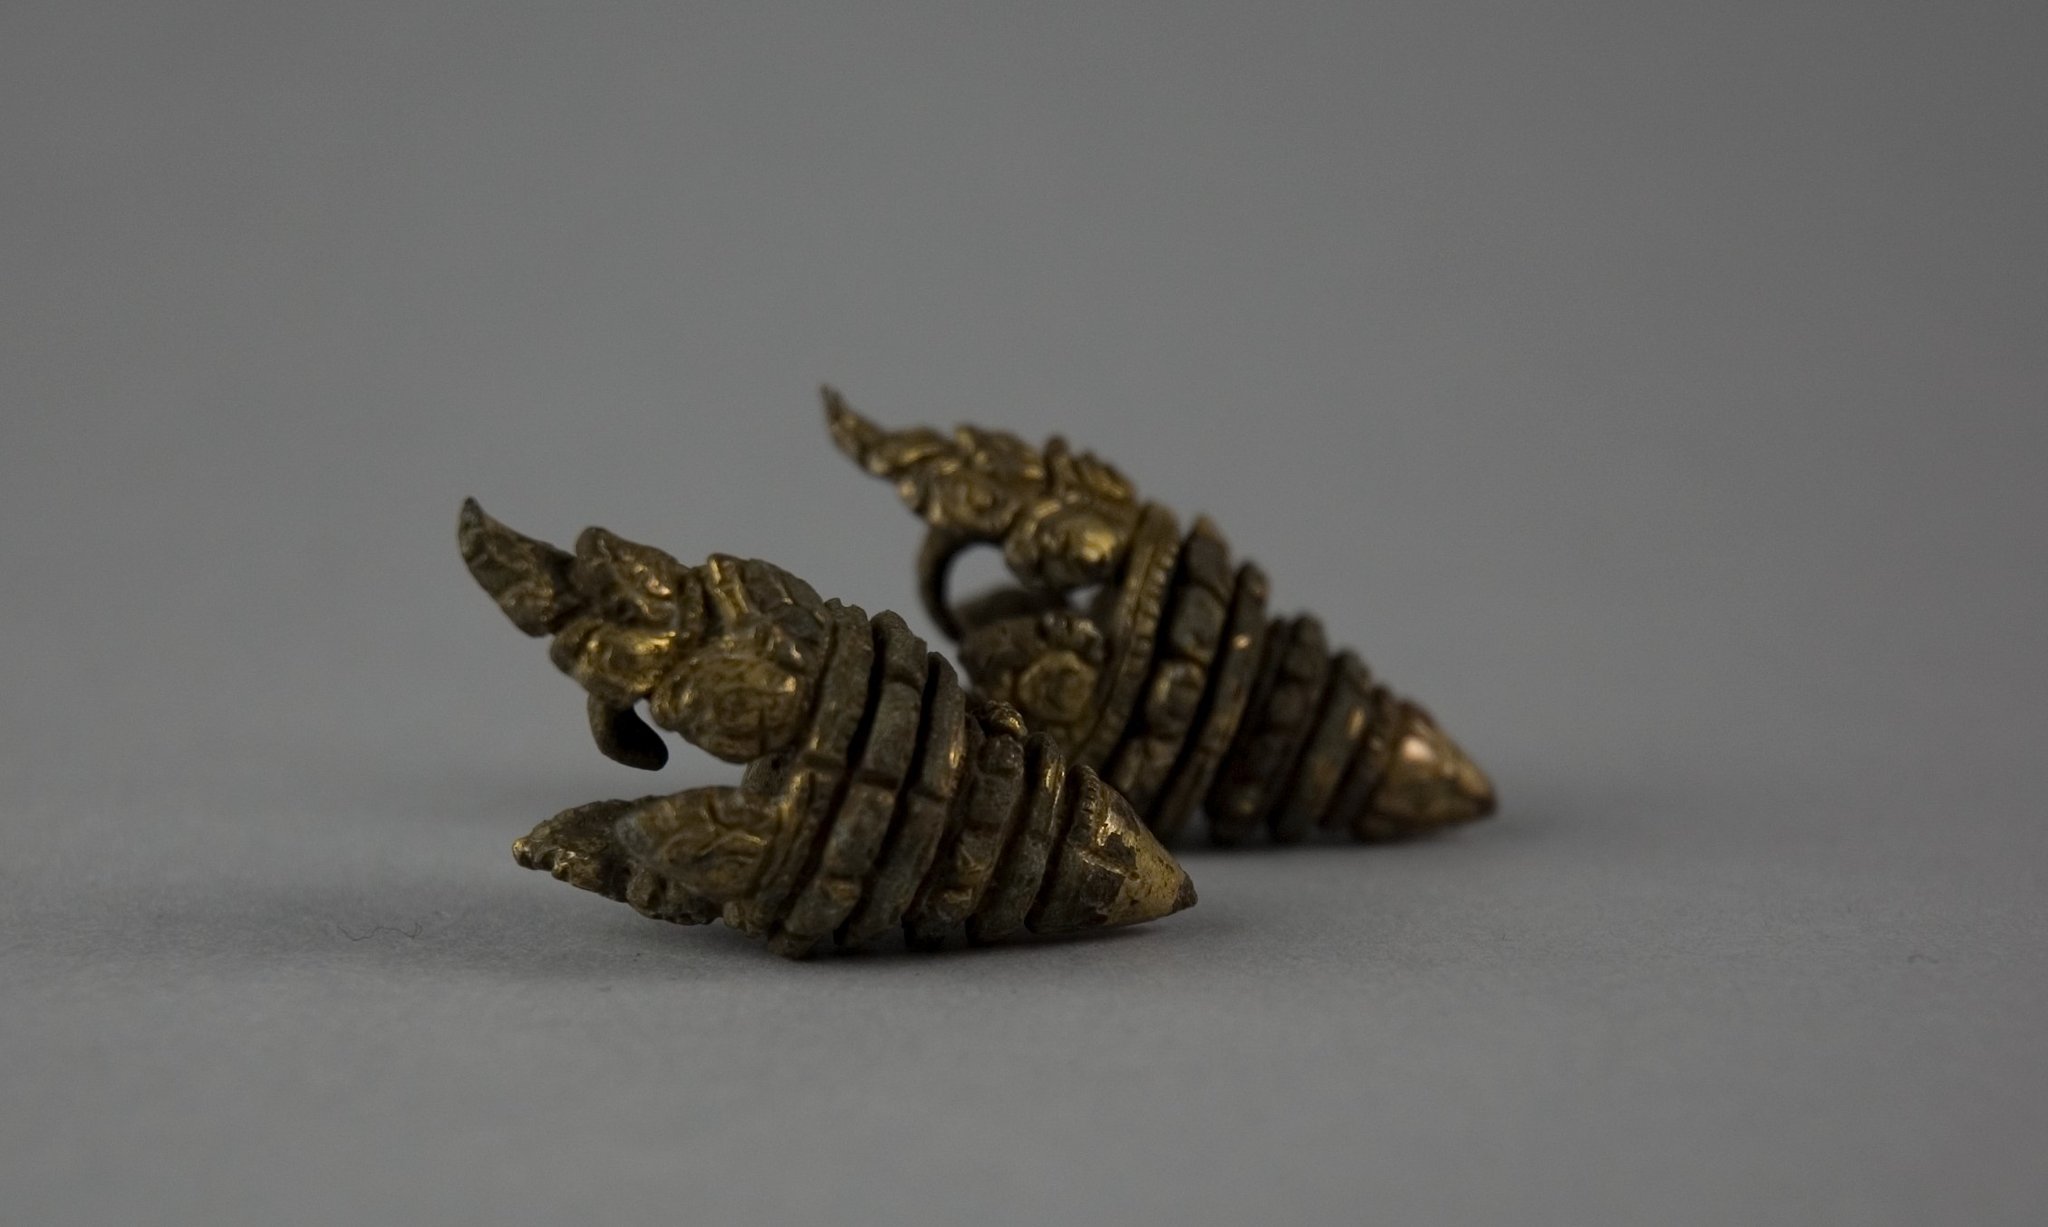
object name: ear clip one from a pair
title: Ear Clip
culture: cambodian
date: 1101-1200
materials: bronze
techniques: gilding